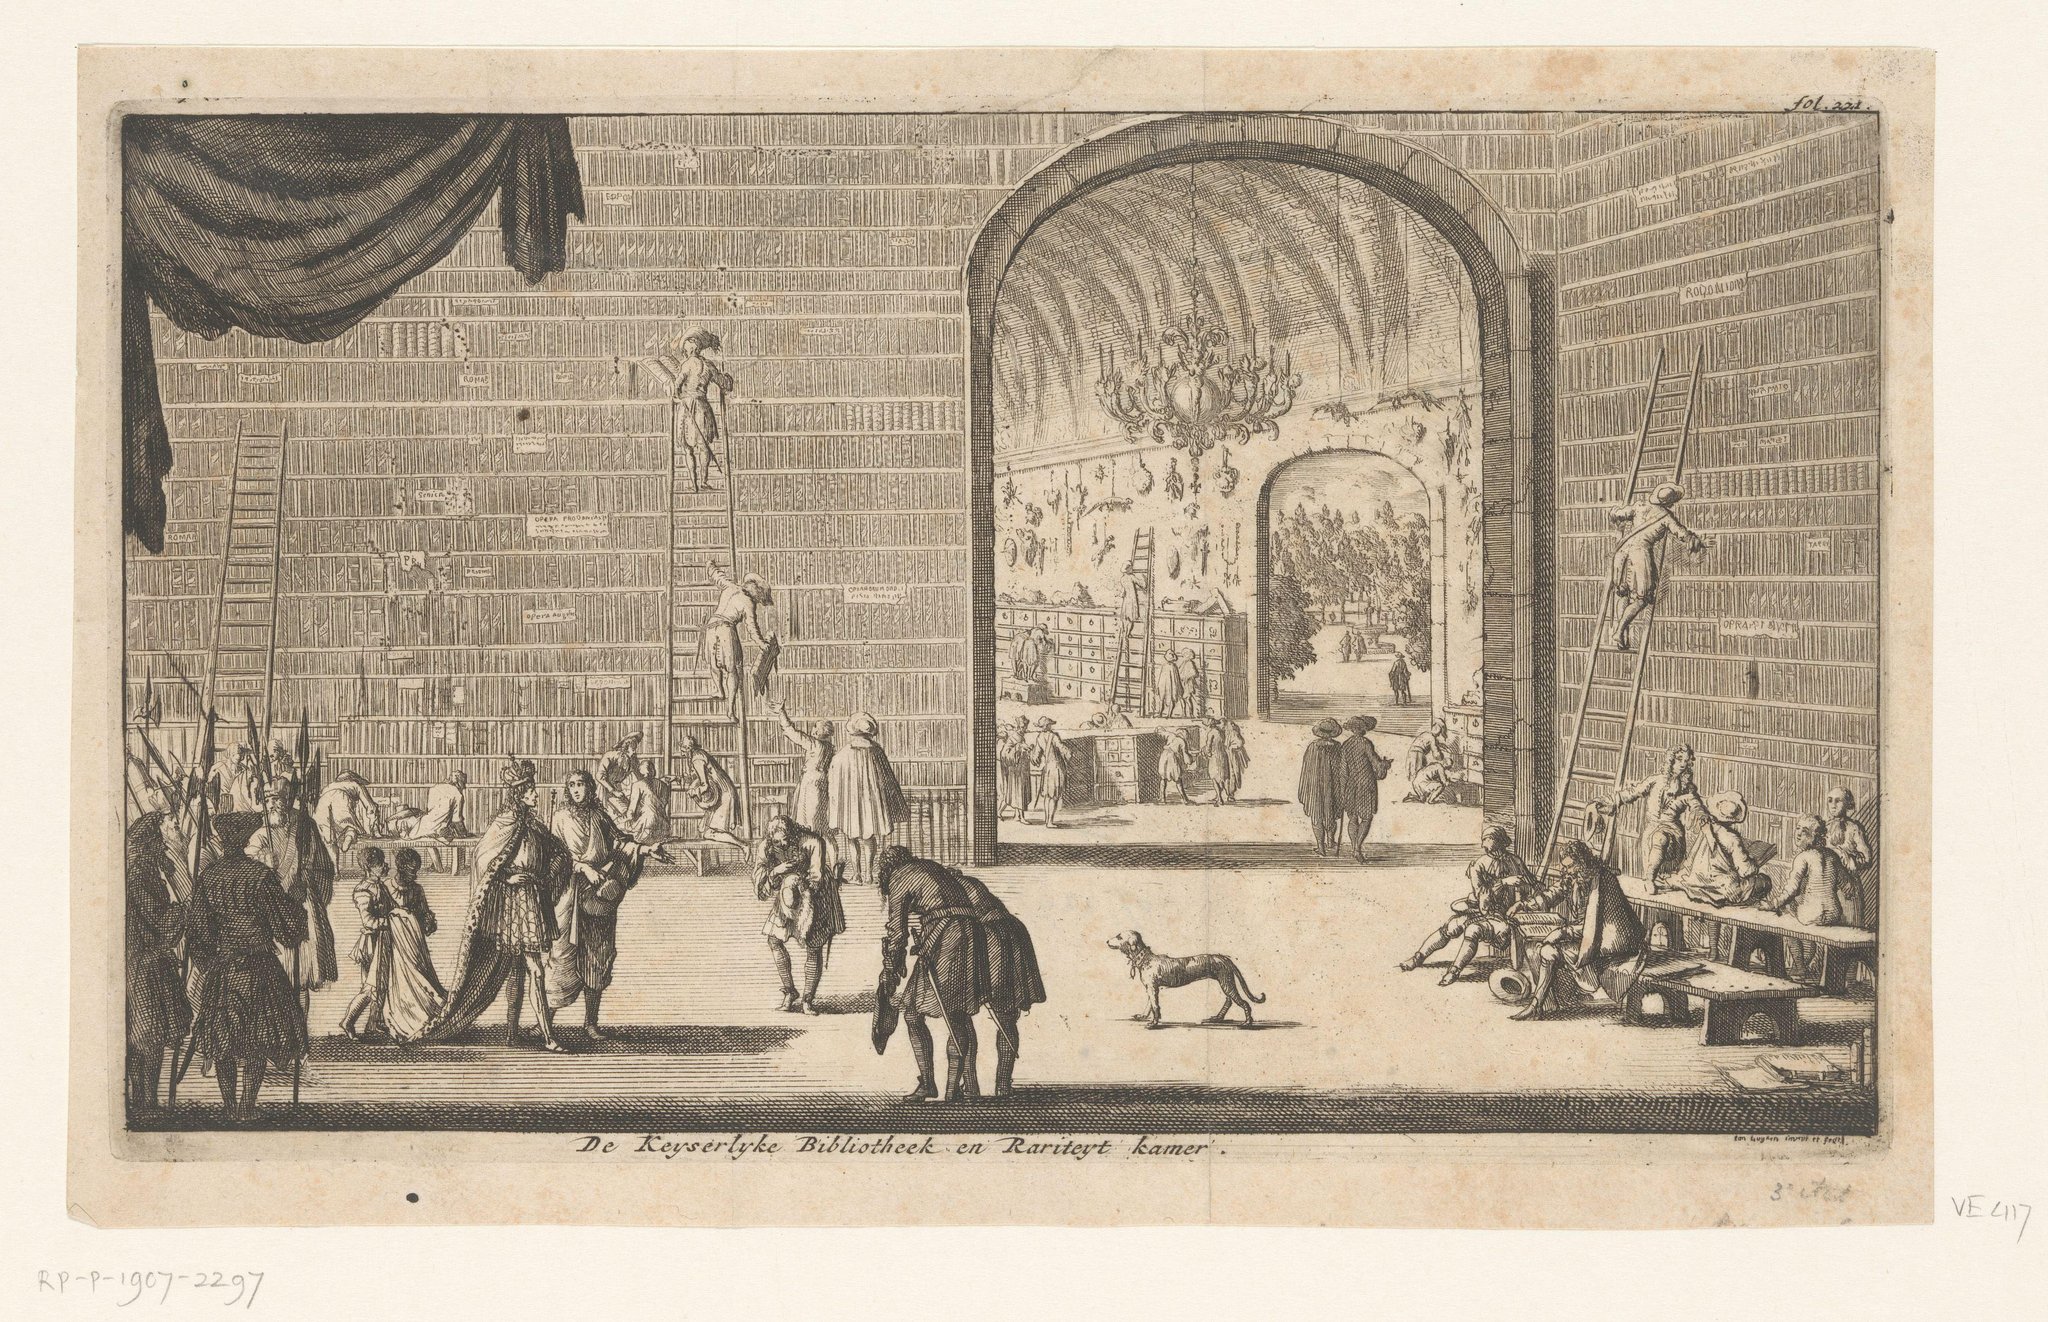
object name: print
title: De Keijserlijke Bibliotheek en Rariteijt Kamer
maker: jan luyken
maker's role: draughtsman, print maker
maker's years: 1649-1712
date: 1682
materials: paper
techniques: etching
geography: amsterdam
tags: study; 'studiolo'; library, cabinet of curiosities, 'kunst- und wunderkammer'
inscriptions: collector's mark: Lugt 2228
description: Gebruikt als illustratie in: Edward Brown, Naauwkeurige en gedenkwaardige reysen van Edward Brown (...) door Nederland, Duytsland, Hongaryen. Amsterdam: Jan Claesz ten Hoorn, 1696.